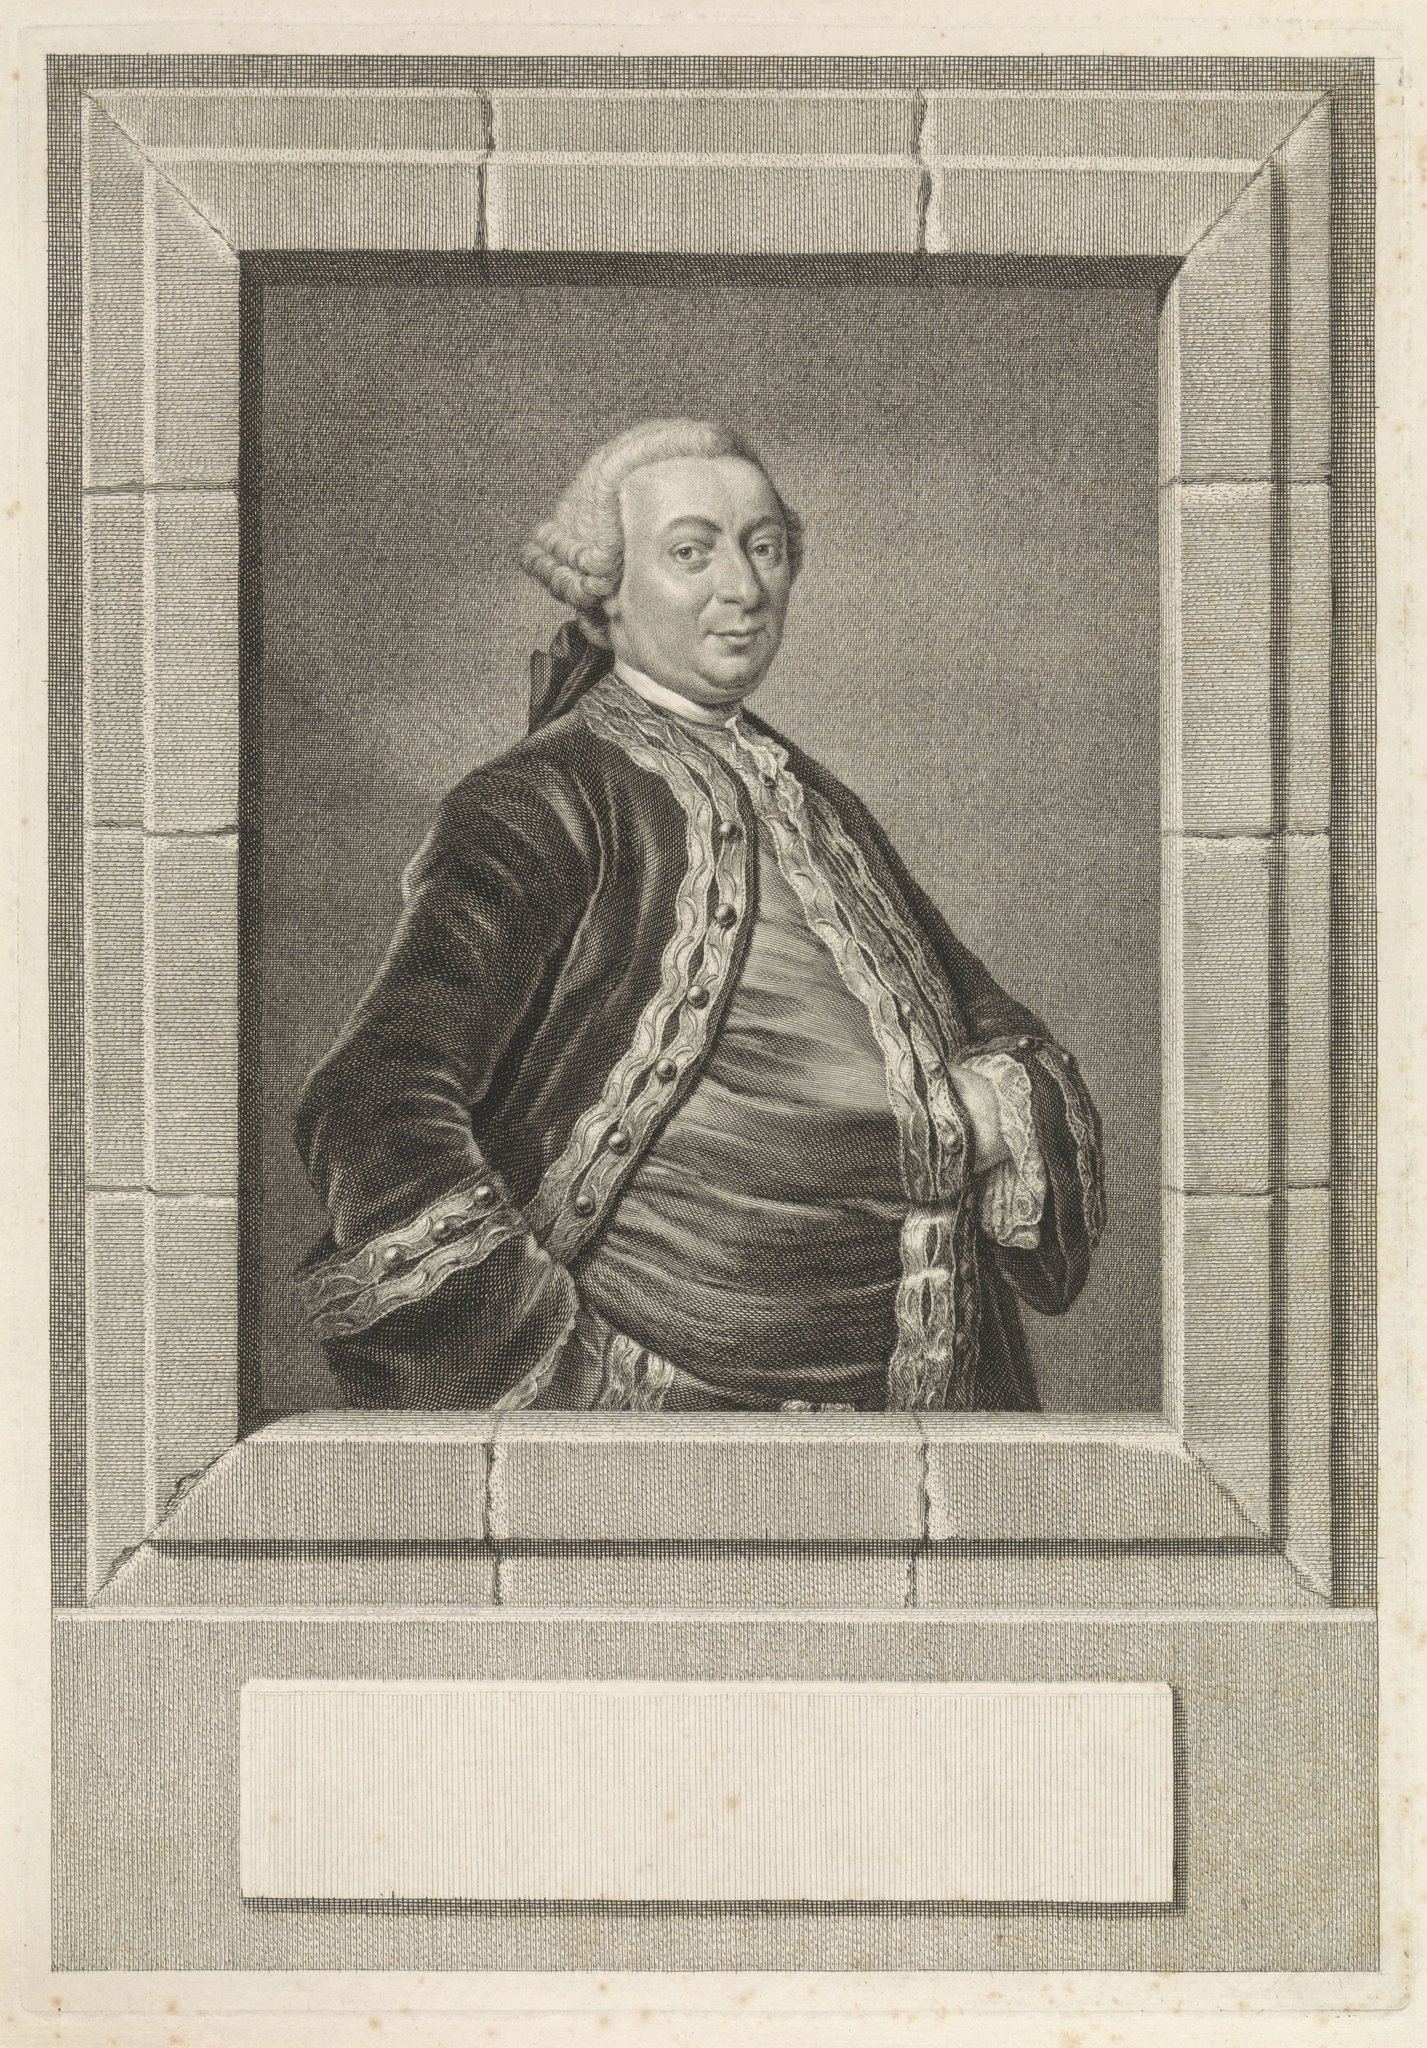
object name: print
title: Portret van Jan Nepveu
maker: jacob houbraken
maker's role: draughtsman, print maker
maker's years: 1698-1780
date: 1668-1770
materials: paper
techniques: engraving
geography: amsterdam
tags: amsterdam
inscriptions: collector's mark: Lugt 240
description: Portret ten halven lijve naar rechts van Jan Nepveu in een architectonisch venster. Onder het portret een leeg veld voor zijn naam.